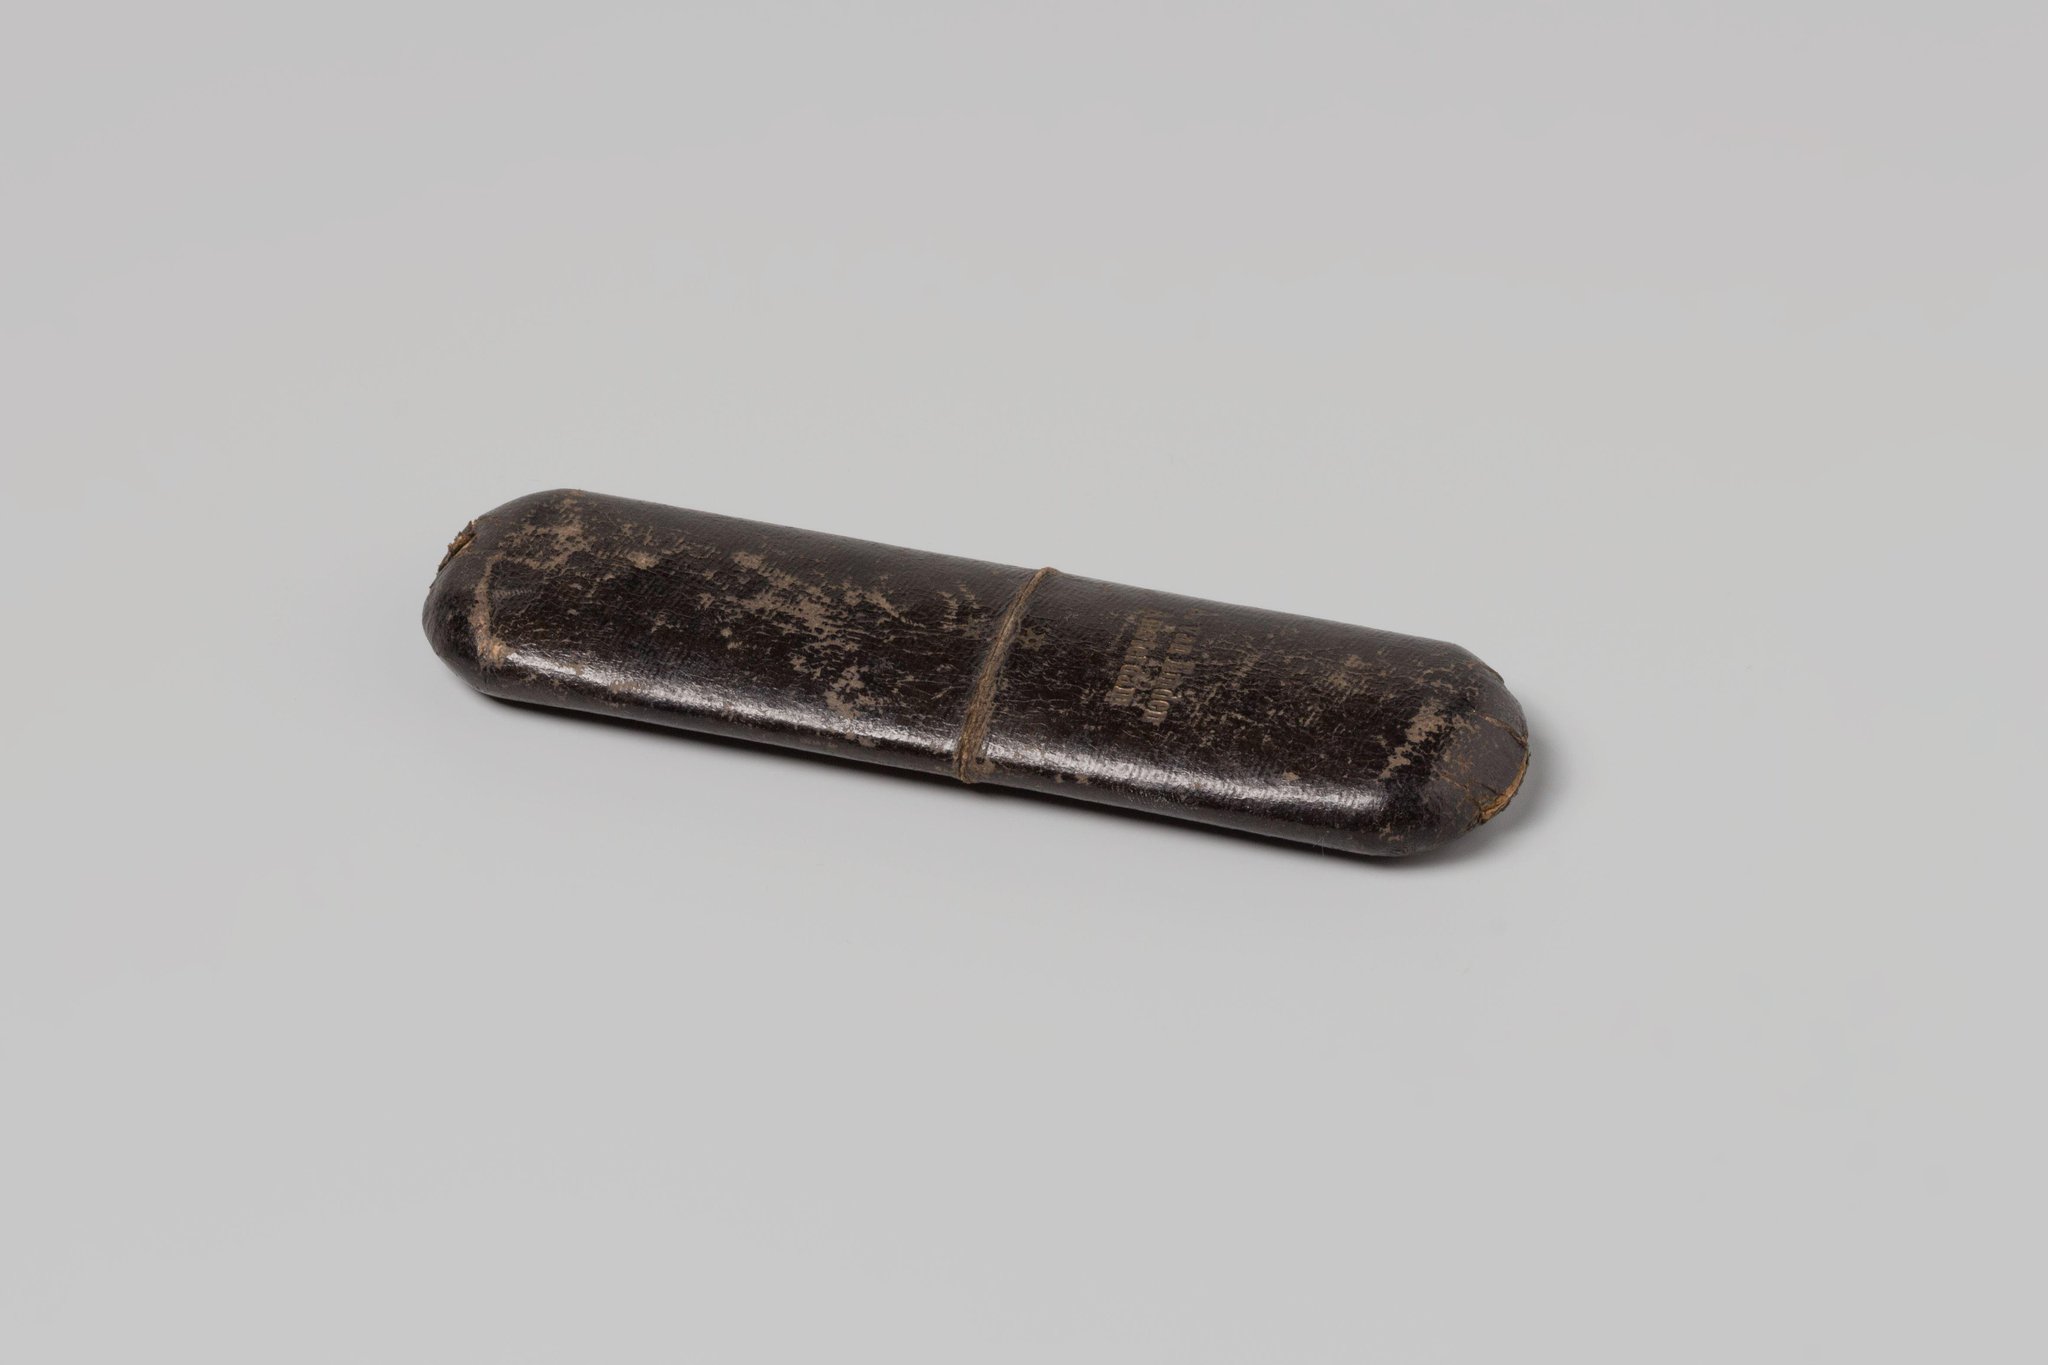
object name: brillenkoker, brillenetui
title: Brillenkoker van hout(?) van buiten beplakt met bruin leer en van binnen met blauw fluweel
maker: Anonymous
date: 1830-1860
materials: cardboard, leather, paper, velvet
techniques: pasting, scooping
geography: amsterdam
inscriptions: address: ‘'A.van Emden / Amsterdam'’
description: Brillenkoker van hout(?) van buiten beplakt met bruin leer en van binnen met blauw fluweel. De opening is als de kaak van een slang met een klepje waarlangs een koperen bandje is gezet. Op de koker: 'A.van Emden / Amsterdam'. Horende bij bril BK-1978-429-A.